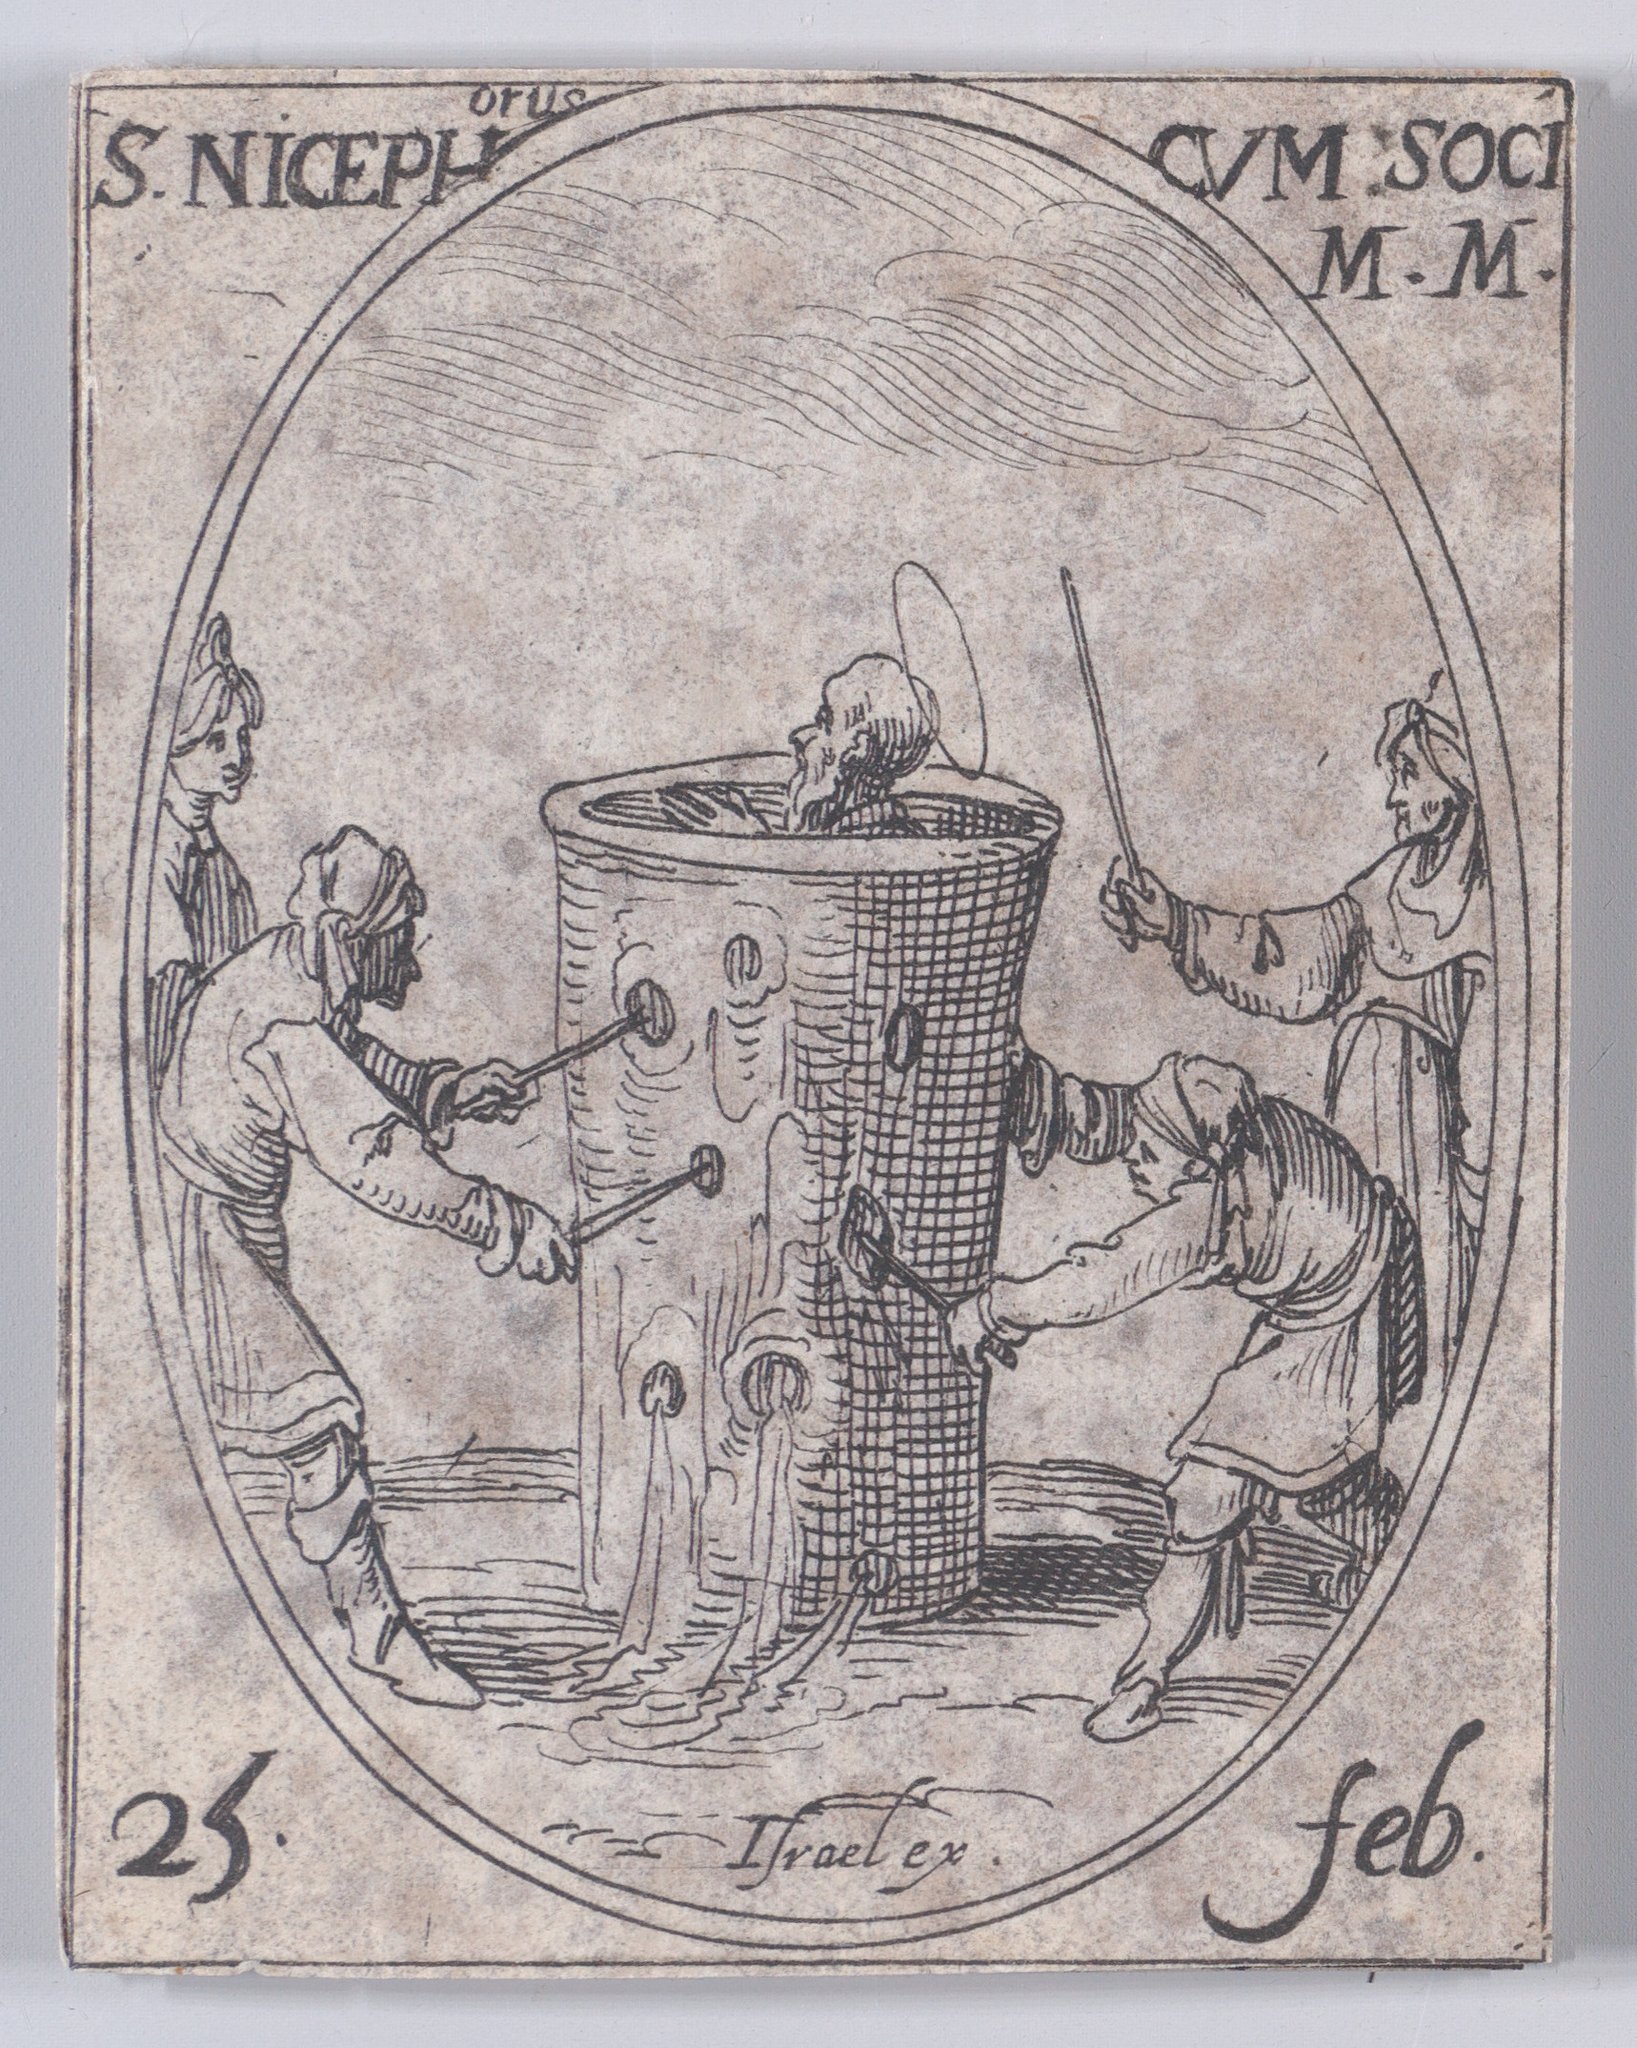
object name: print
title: S. Nicéphore et Ses Compagnons (St. Nicephorus and His Companions), February 25th, from "Les Images De Tous Les Saincts et Saintes de L'Année" (Images of All of the Saints and Religious Events of the Year)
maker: jacques callot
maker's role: artist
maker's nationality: french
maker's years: 1592-1635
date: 1636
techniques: etching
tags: men,saints